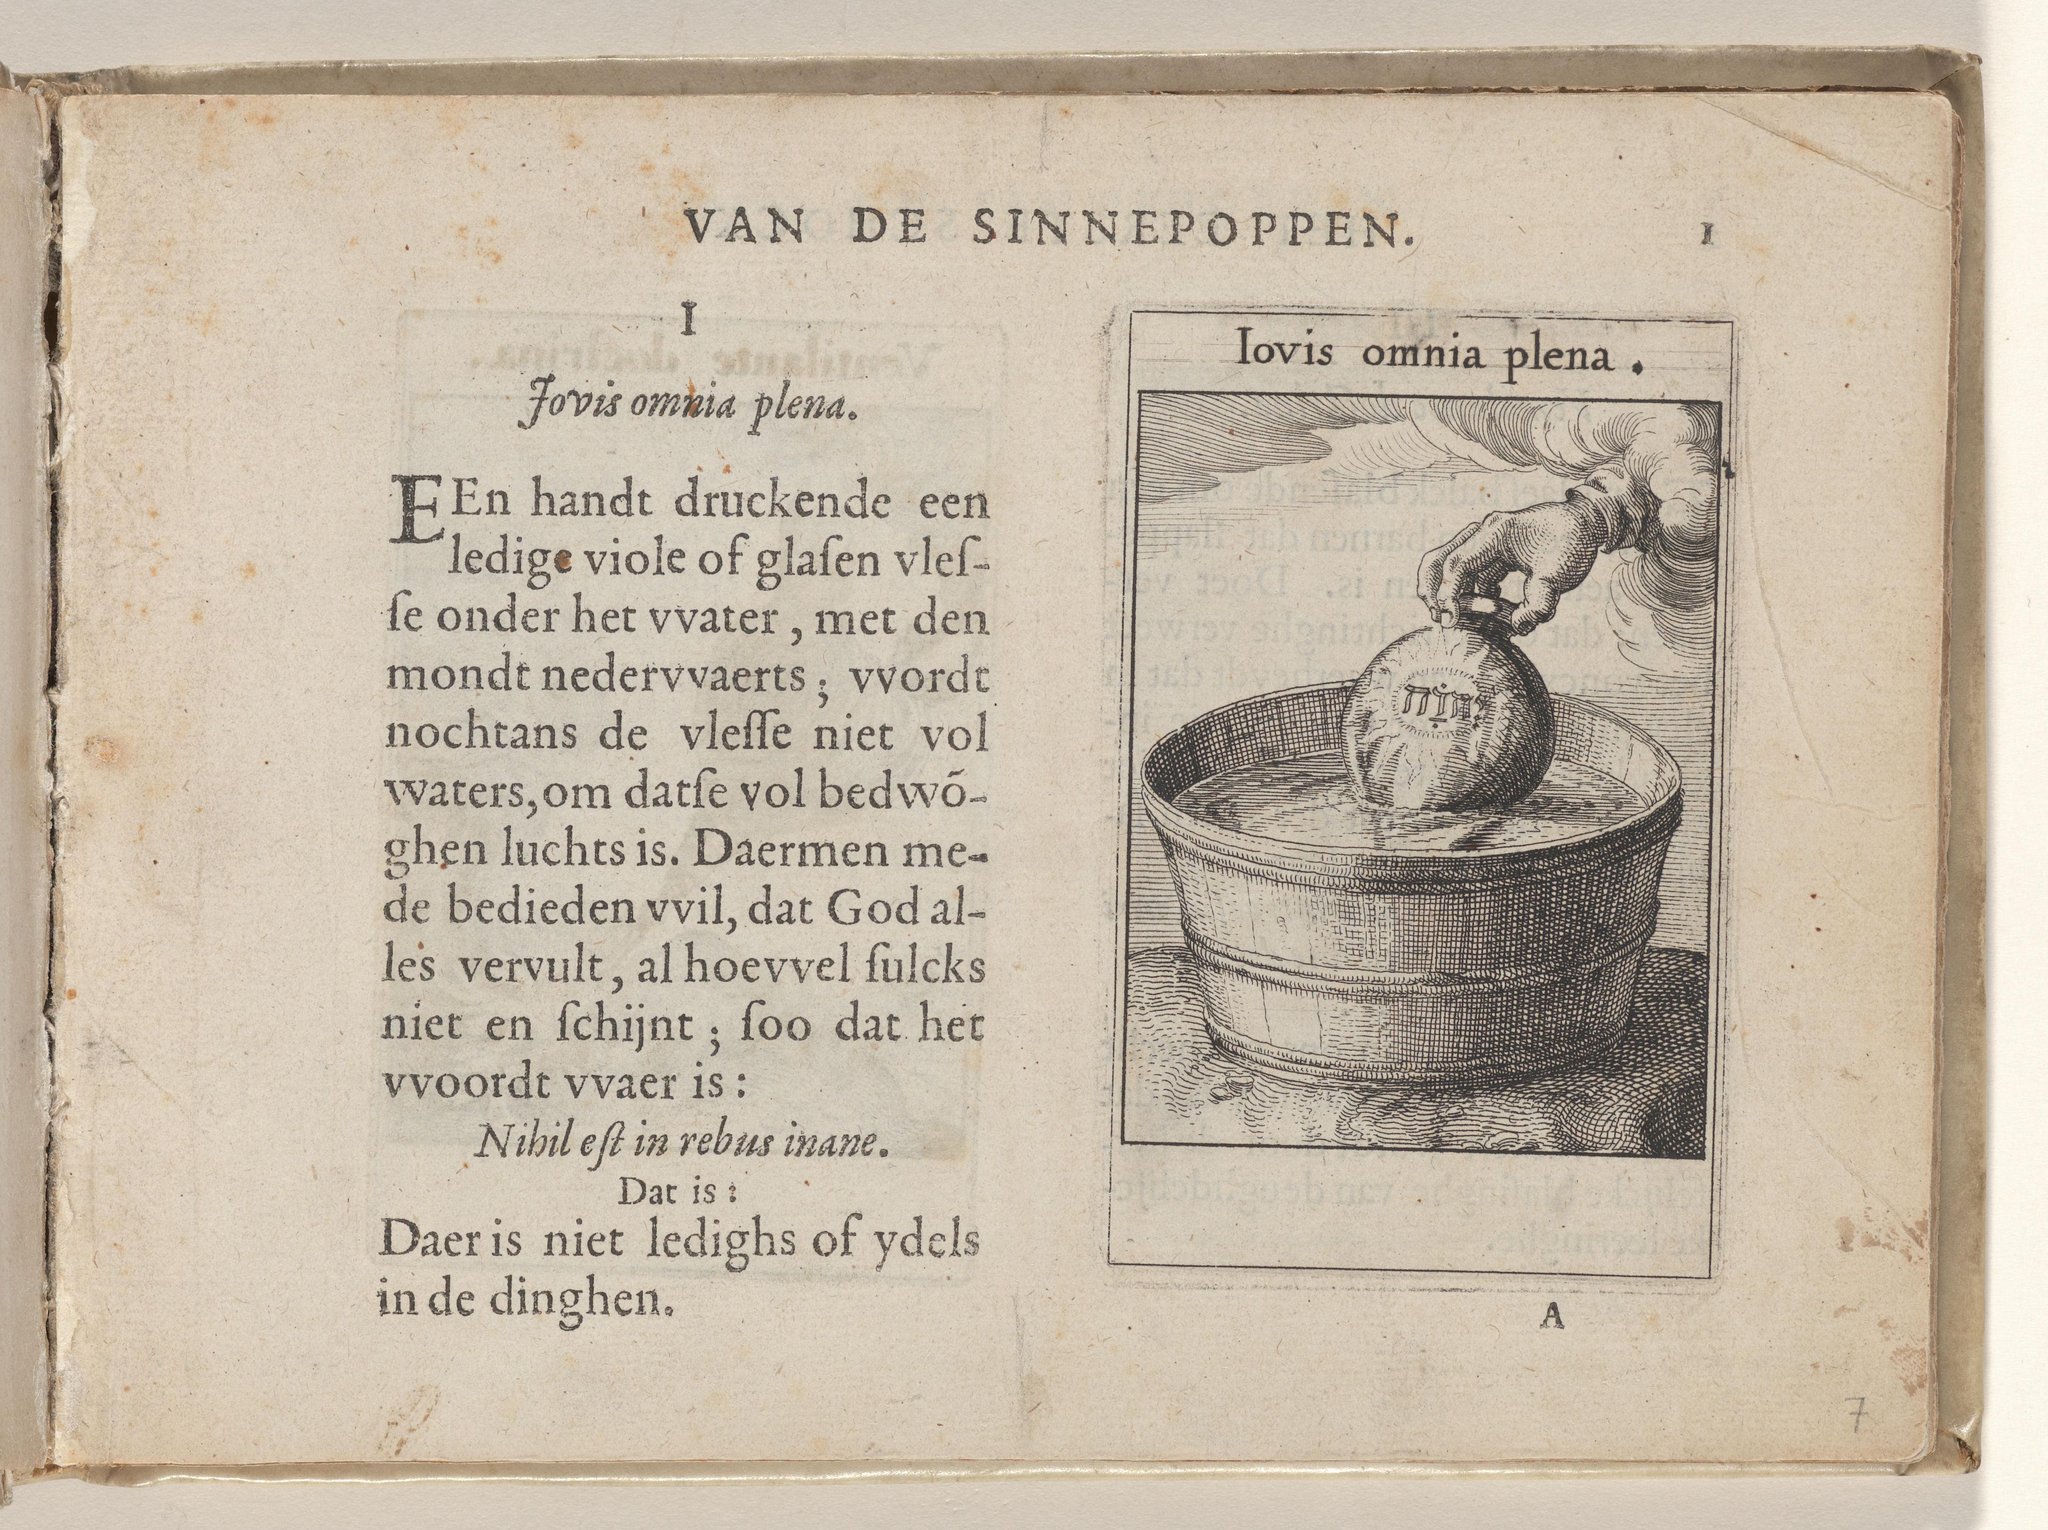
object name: album leaf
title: I Jovis omnia plena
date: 1614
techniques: engraving, printing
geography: the hague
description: I Jovis omnia plena. Eerste schok. Onderdeel van 'Sinnepoppen', R. Visscher, 1614.